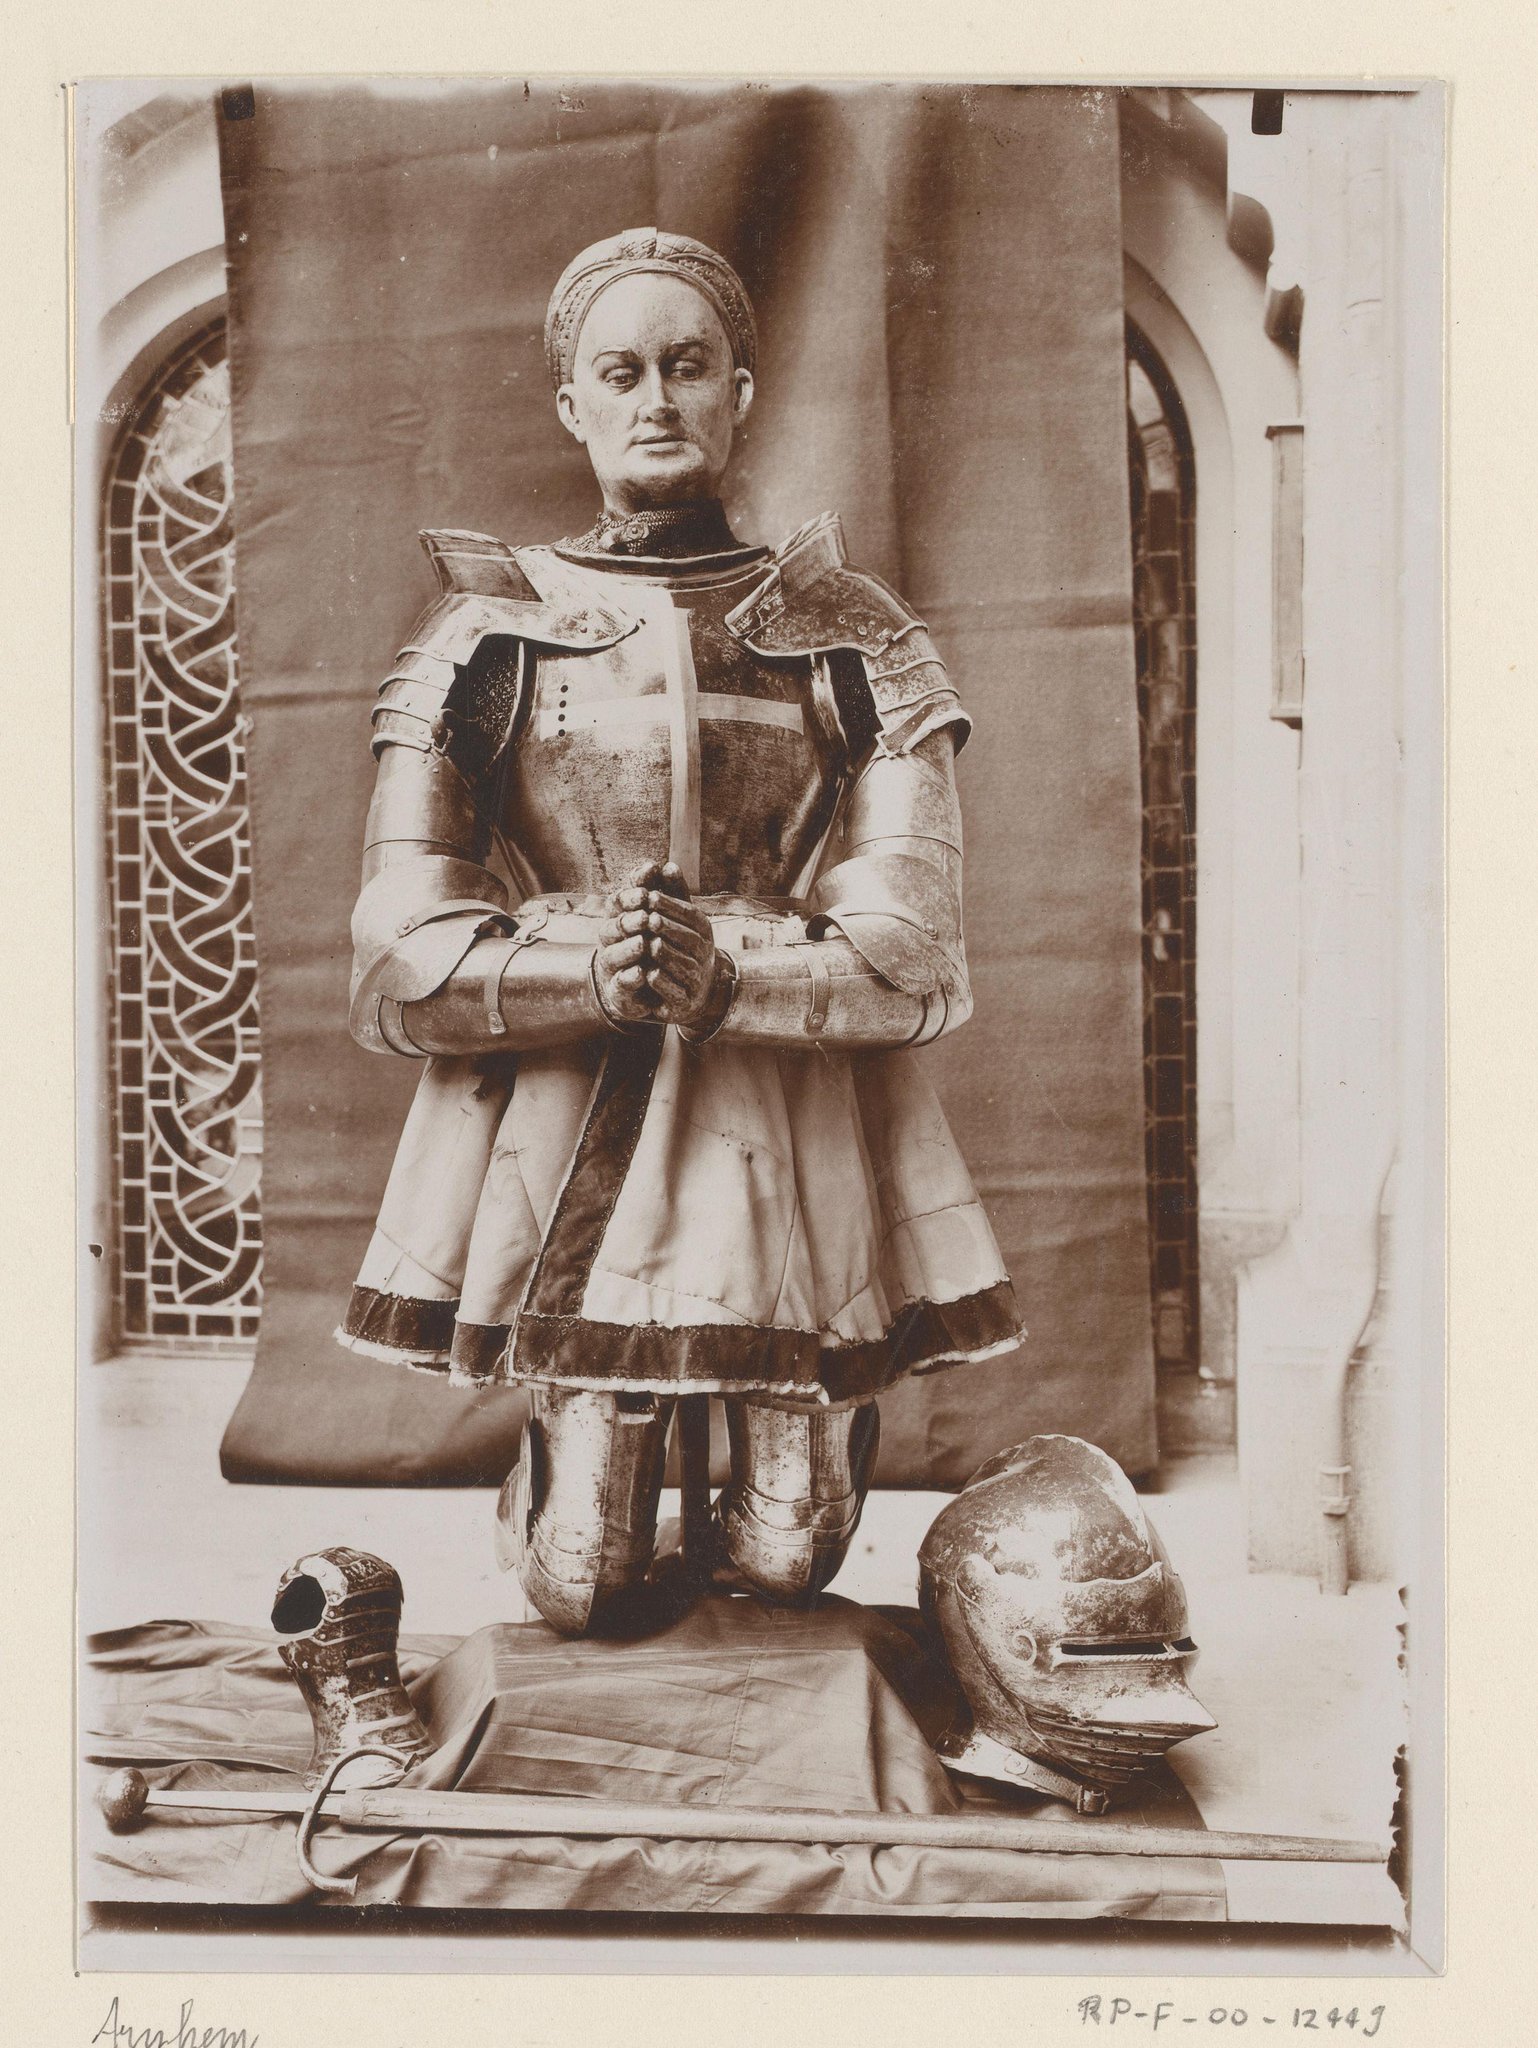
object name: photograph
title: Beeld van Karel van Egmond, hertog van Gelre, in de Eusebiuskerk te Arnhem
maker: Anonymous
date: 1880-1910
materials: paper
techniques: collodion silver print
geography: arnhem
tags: grave, arnhem, earl, karel van egmond, piece of sculpture, reproduction of a piece of sculpture, one person praying